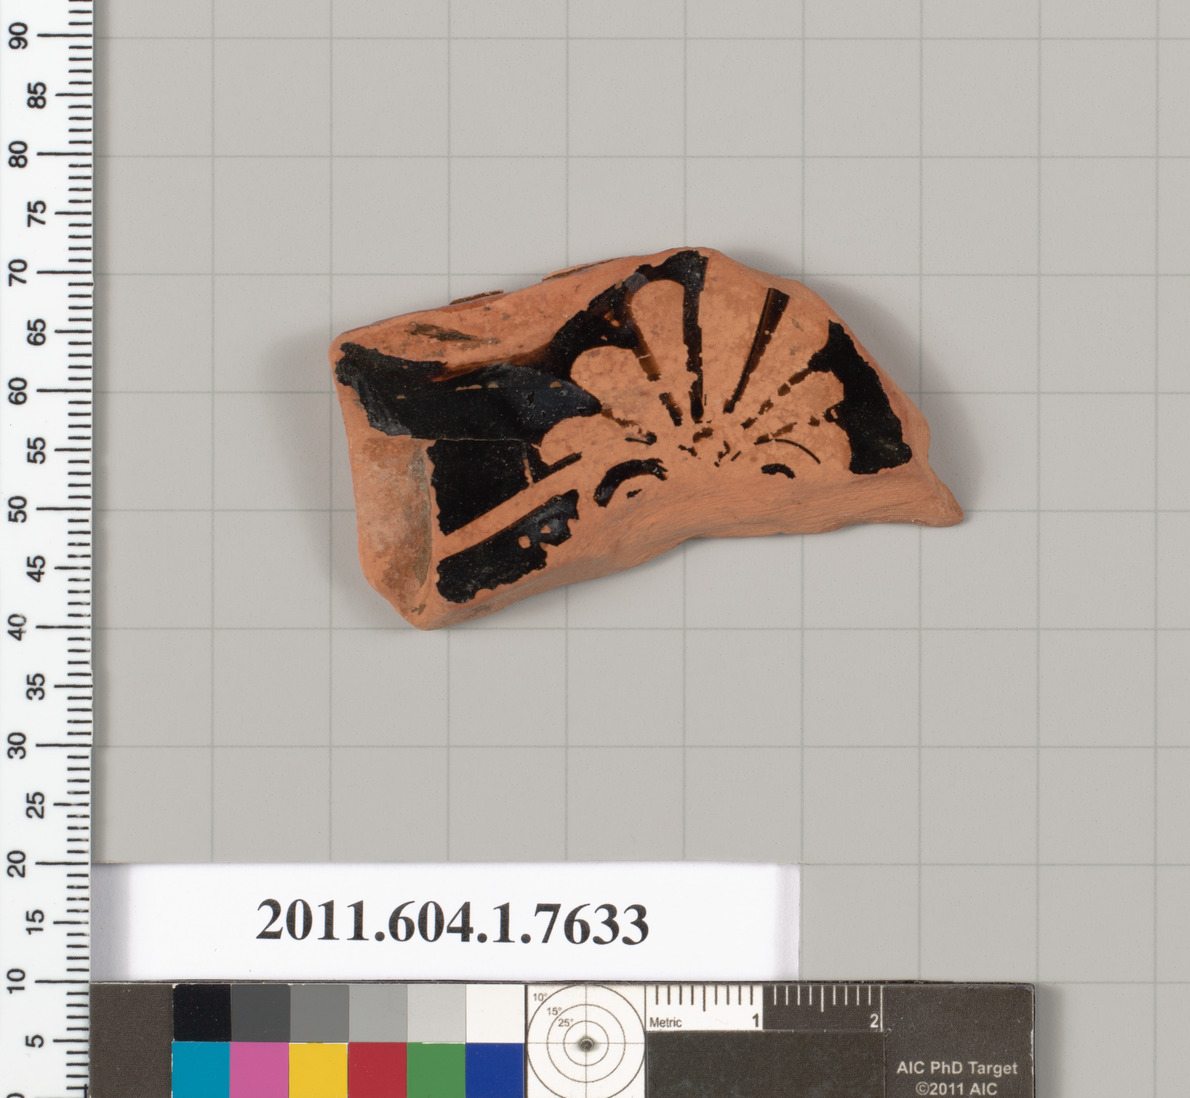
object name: kylix fragment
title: Terracotta fragment of a kylix (drinking cup)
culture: greek, attic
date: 460-450 BCE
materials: terracotta